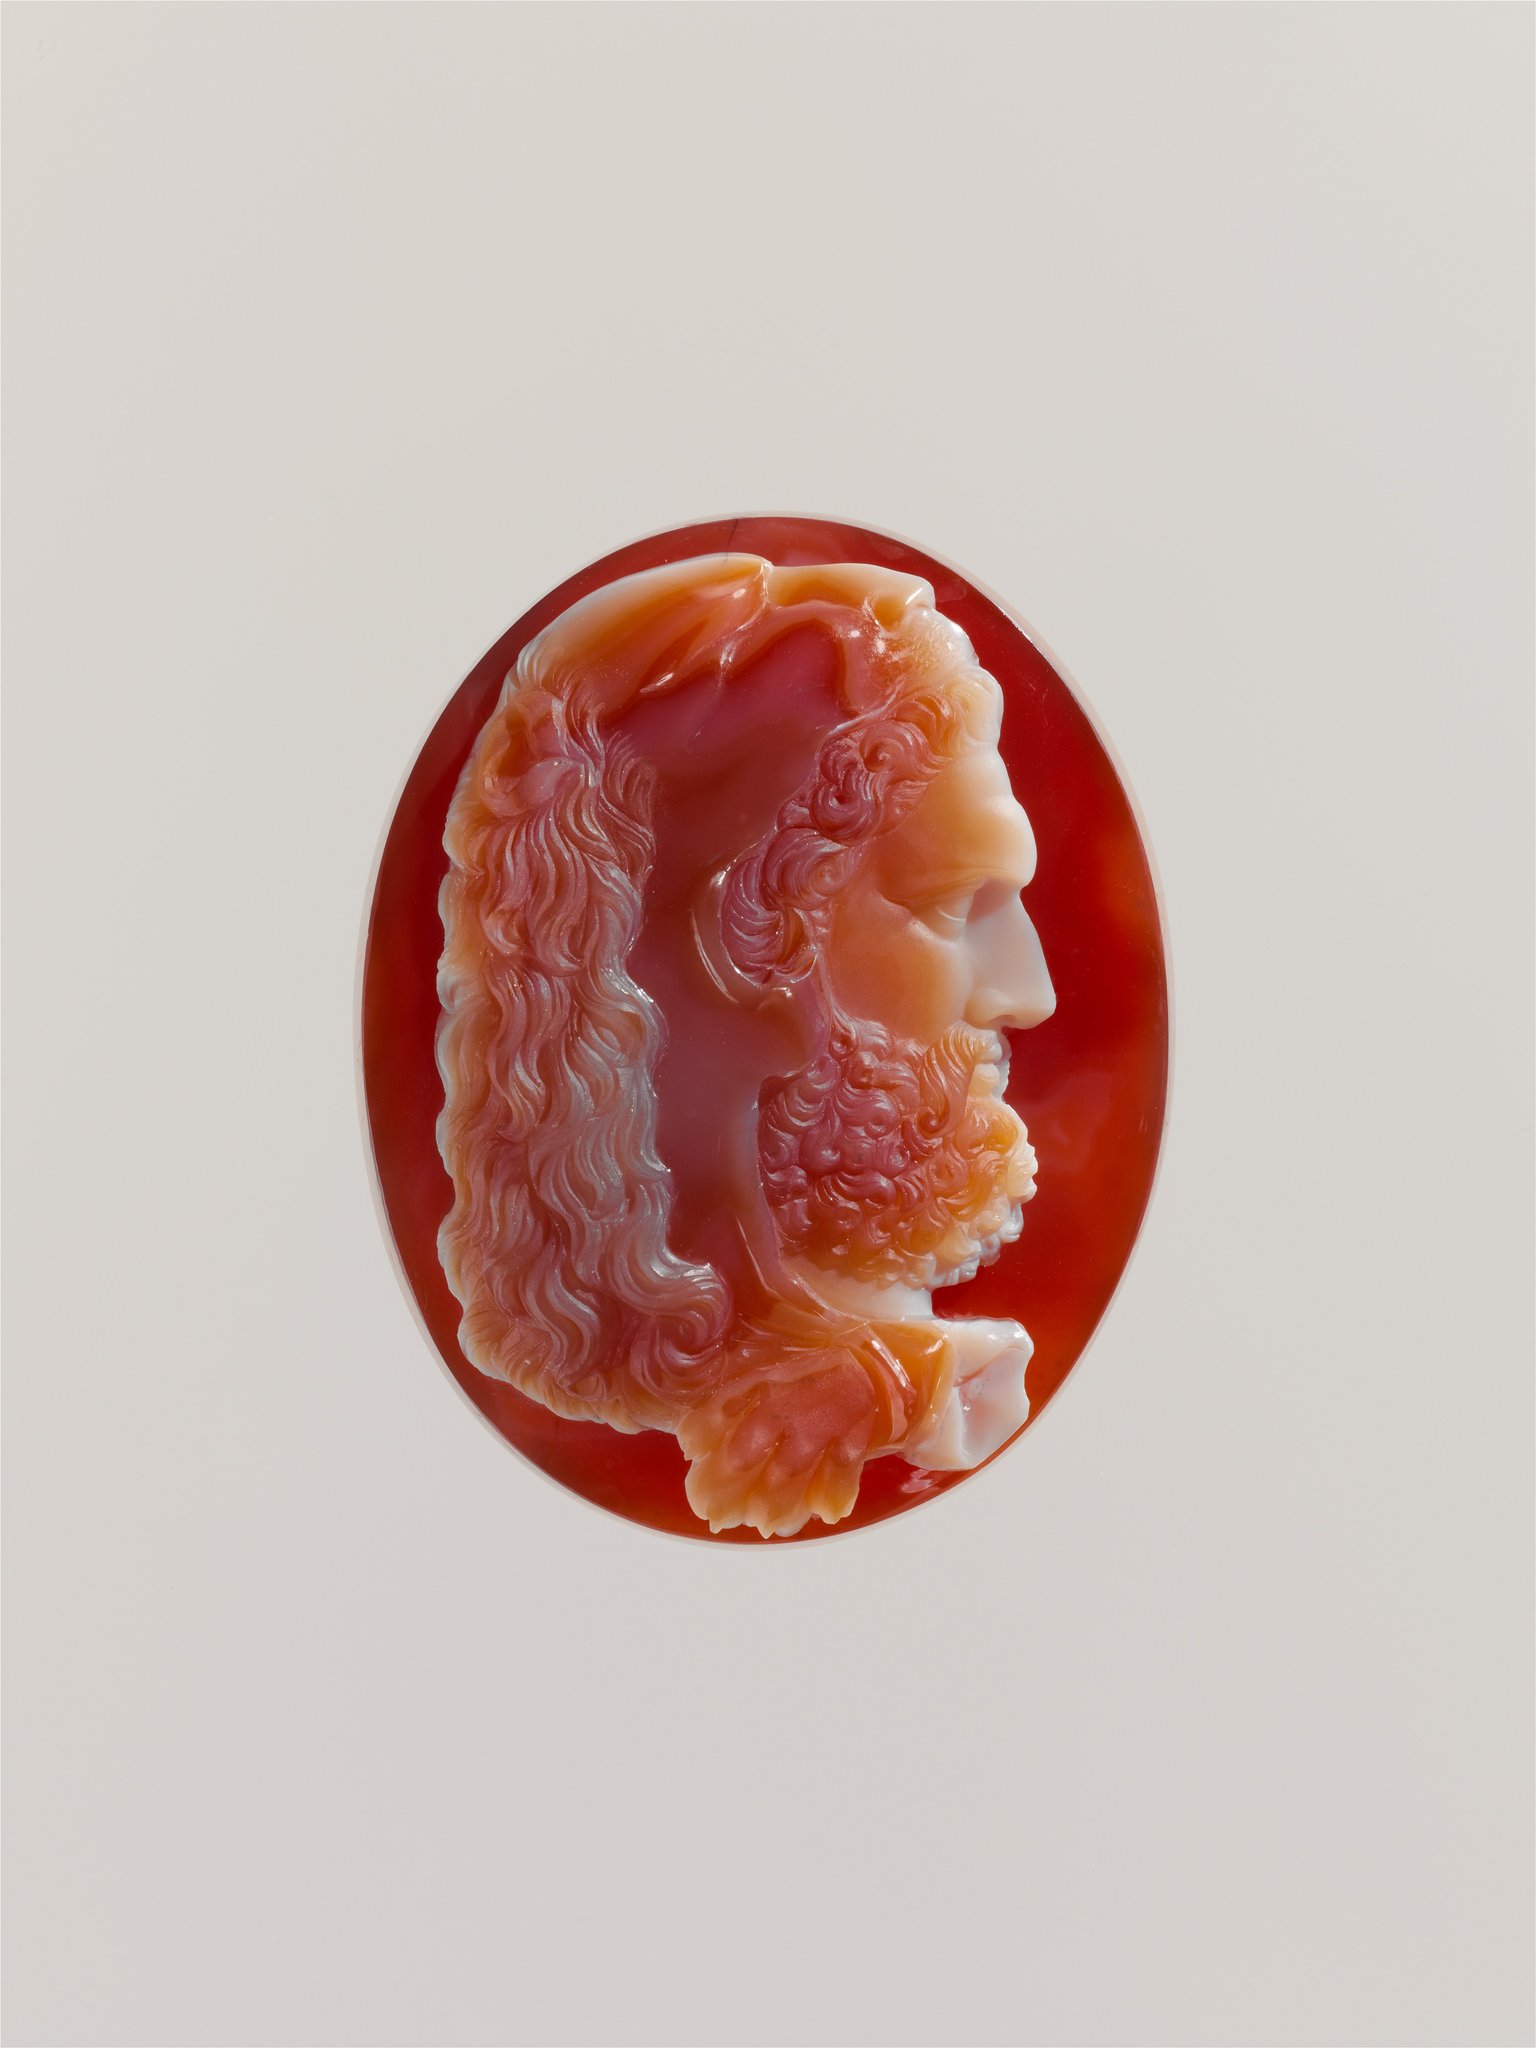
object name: cameo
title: Head of Hercules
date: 1834-1866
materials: gemstone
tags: heads,hercules